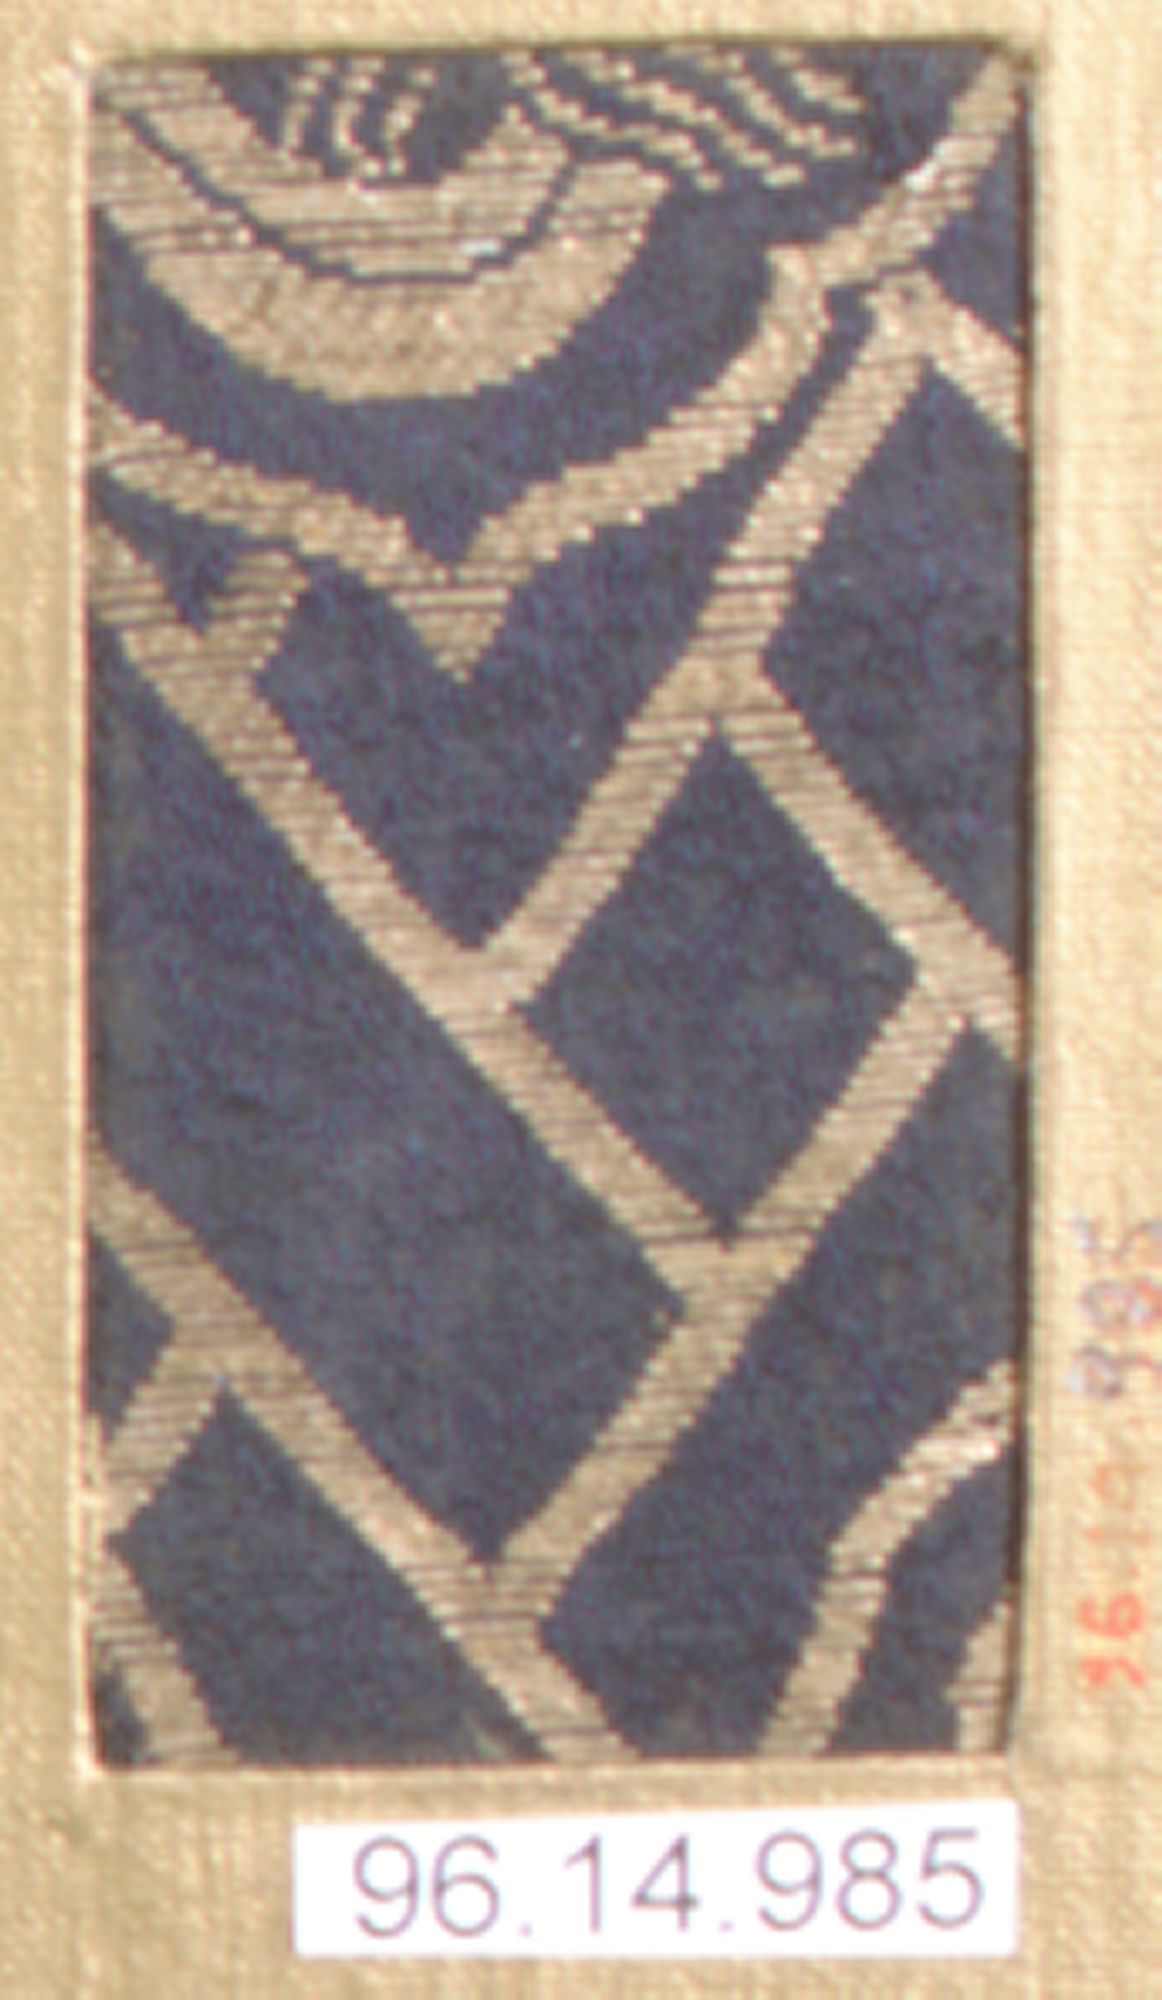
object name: piece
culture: japanese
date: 1701-1900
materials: silk